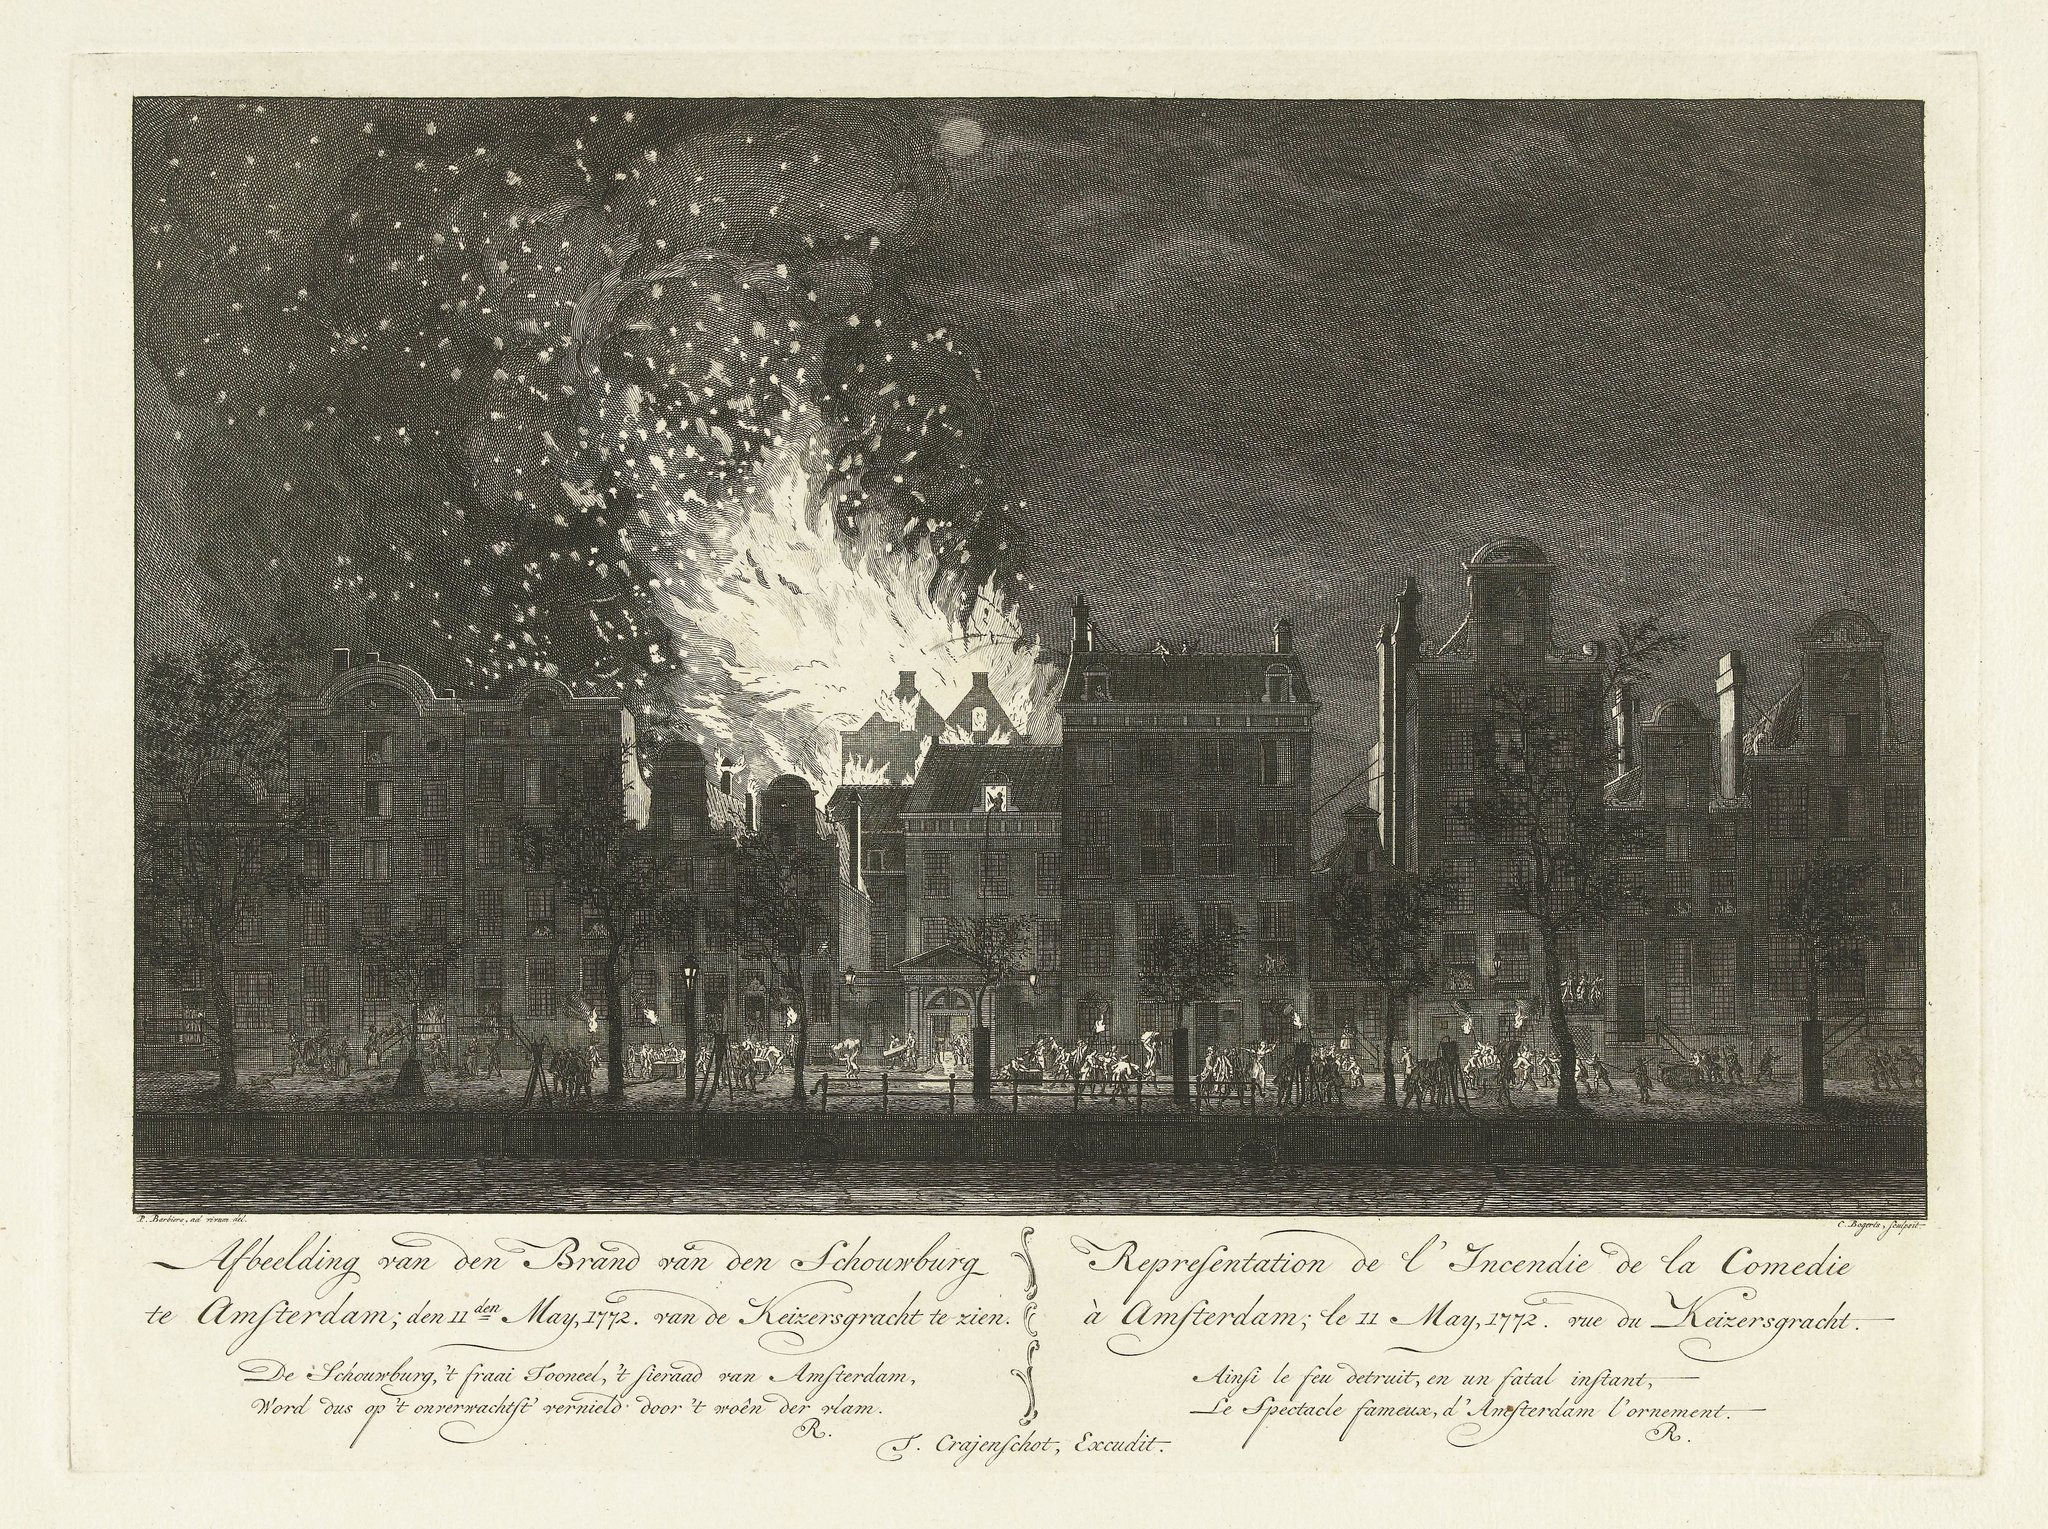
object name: print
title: Afbeelding van den Brand van den Schouwburg te Amsterdam; den 11den May, 1772. van de Keizersgracht te zien / Representation de l'Incendie de la Comedie à Amsterdam; le 11 May, 1772. vue du Keizersgracht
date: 1772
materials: paper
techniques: engraving, etching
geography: amsterdam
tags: on fire, ablaze, theatre, theatrical performance, theatre (building), fire-fighting, rescue from fire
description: Gezicht op de laaiende brand in de Amsterdamse Schouwburg op 11 mei 1772, gezien vanaf de overzijde van de Keizersgracht. De brandweer brengt brandspuitpompen in gereedheid. Uit de schouwburg worden kisten en koffers gedragen. Onder de voorstelling de titel en een tweeregelig vers in het Nederlands (links) en Frans (rechts). Onderdeel van een serie van vier prenten met titelprent over de brand in de Amsterdamse Schouwburg.